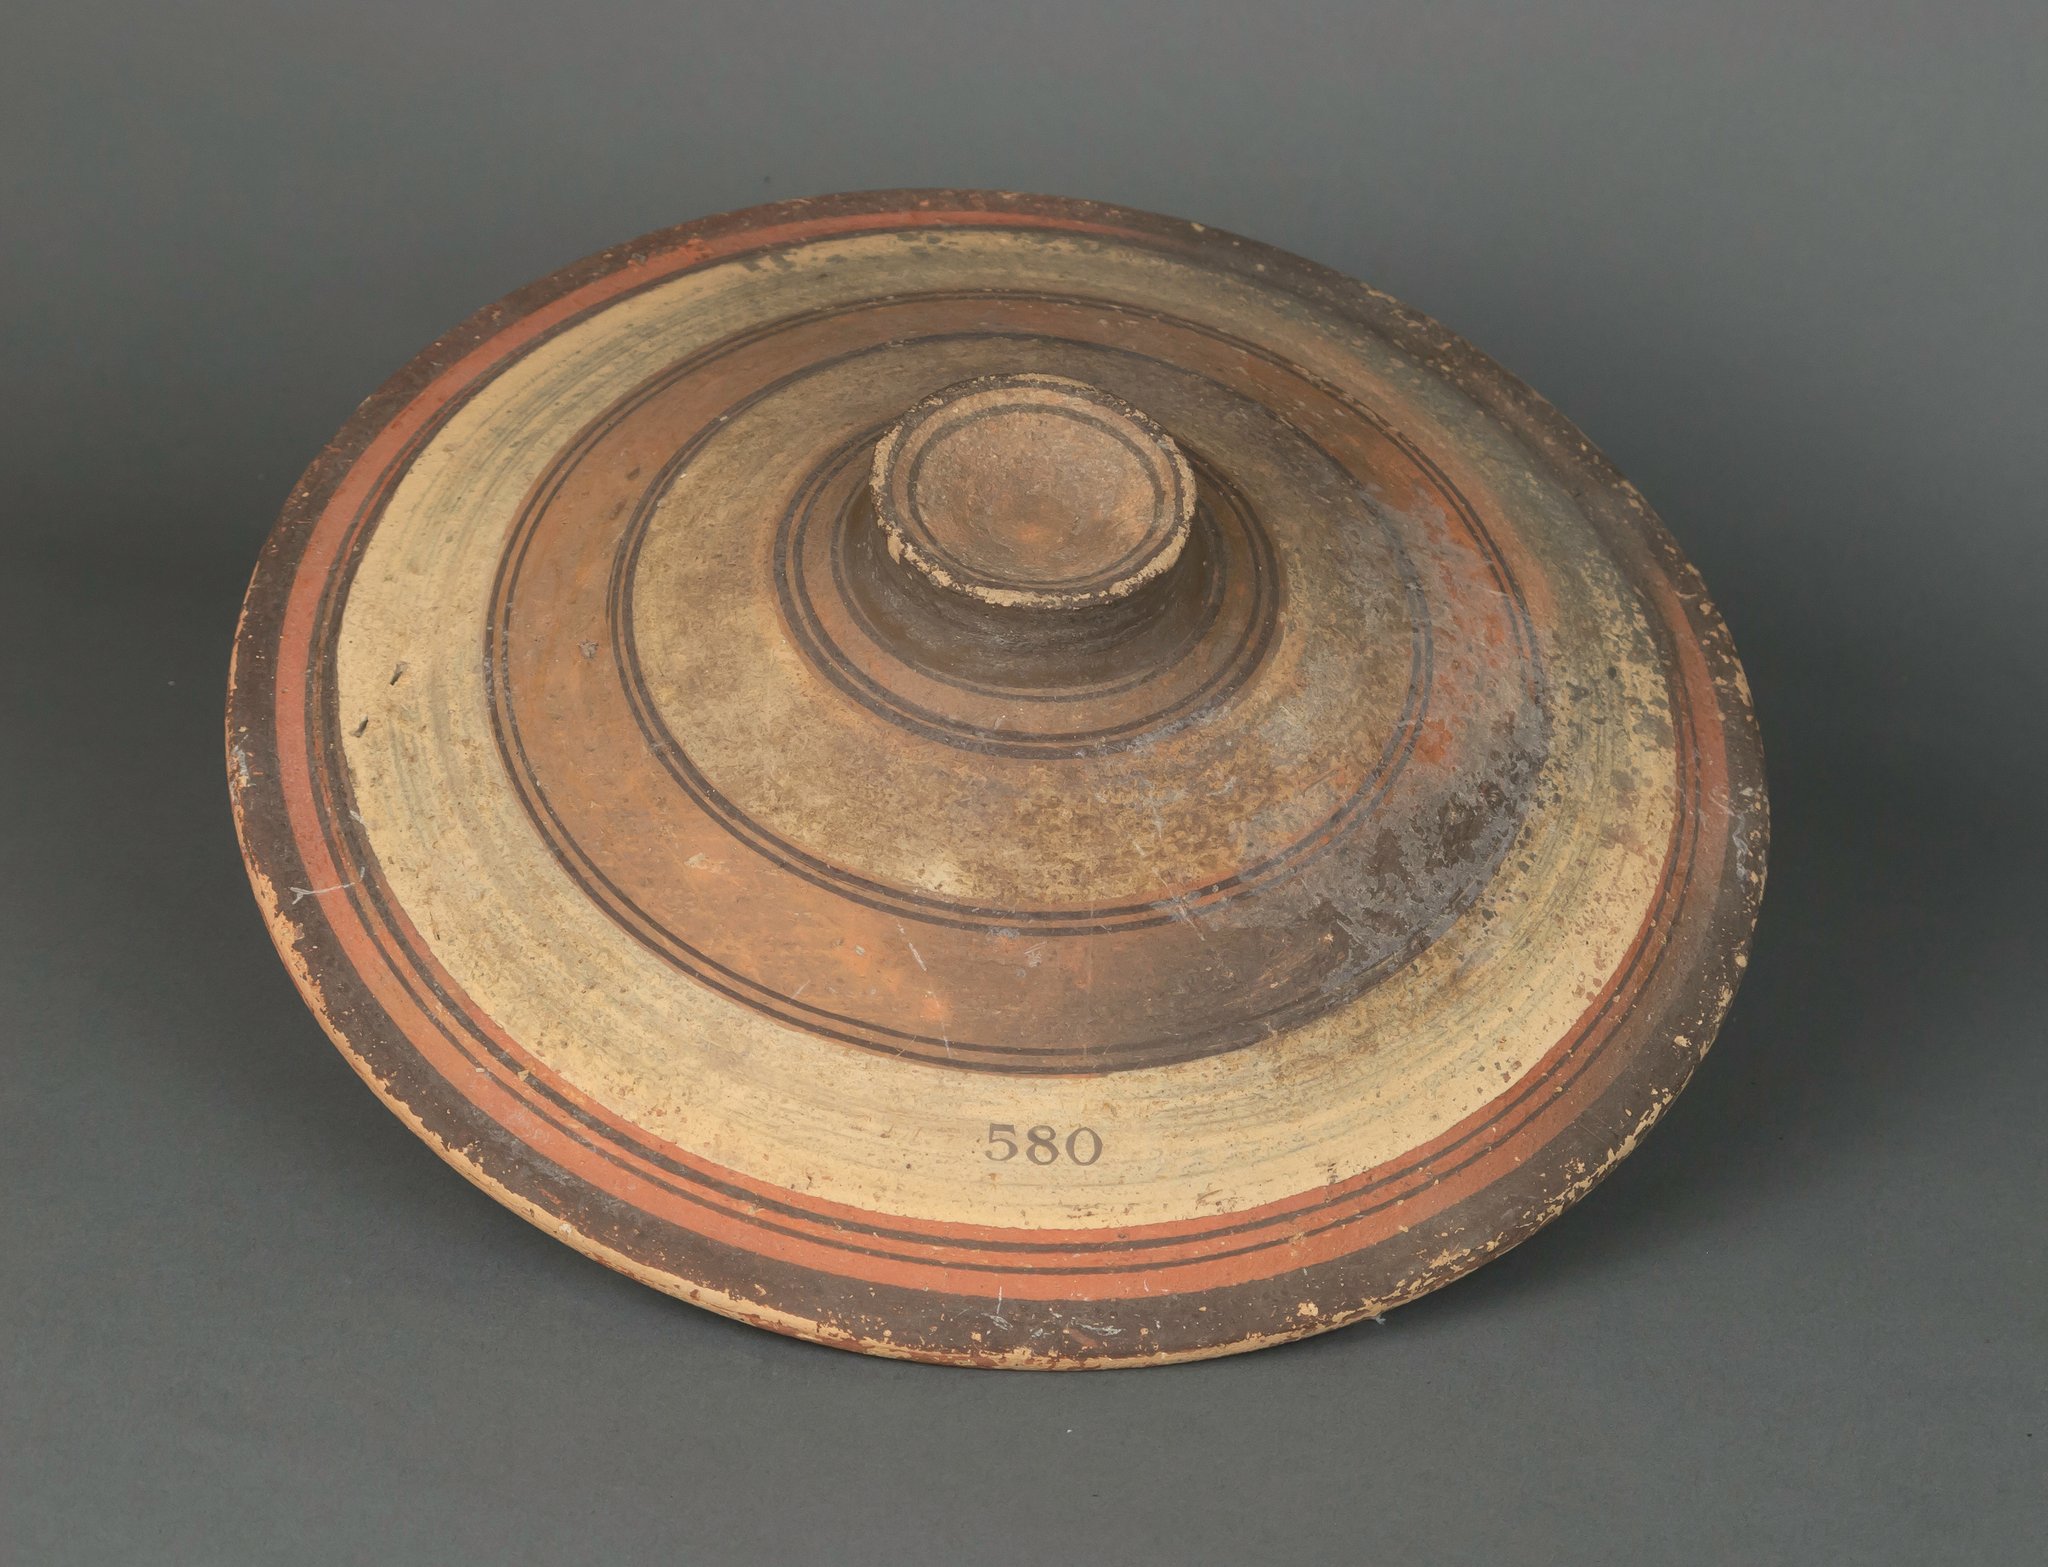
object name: lid of a bowl with knob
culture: cypriot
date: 750-480 BCE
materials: terracotta